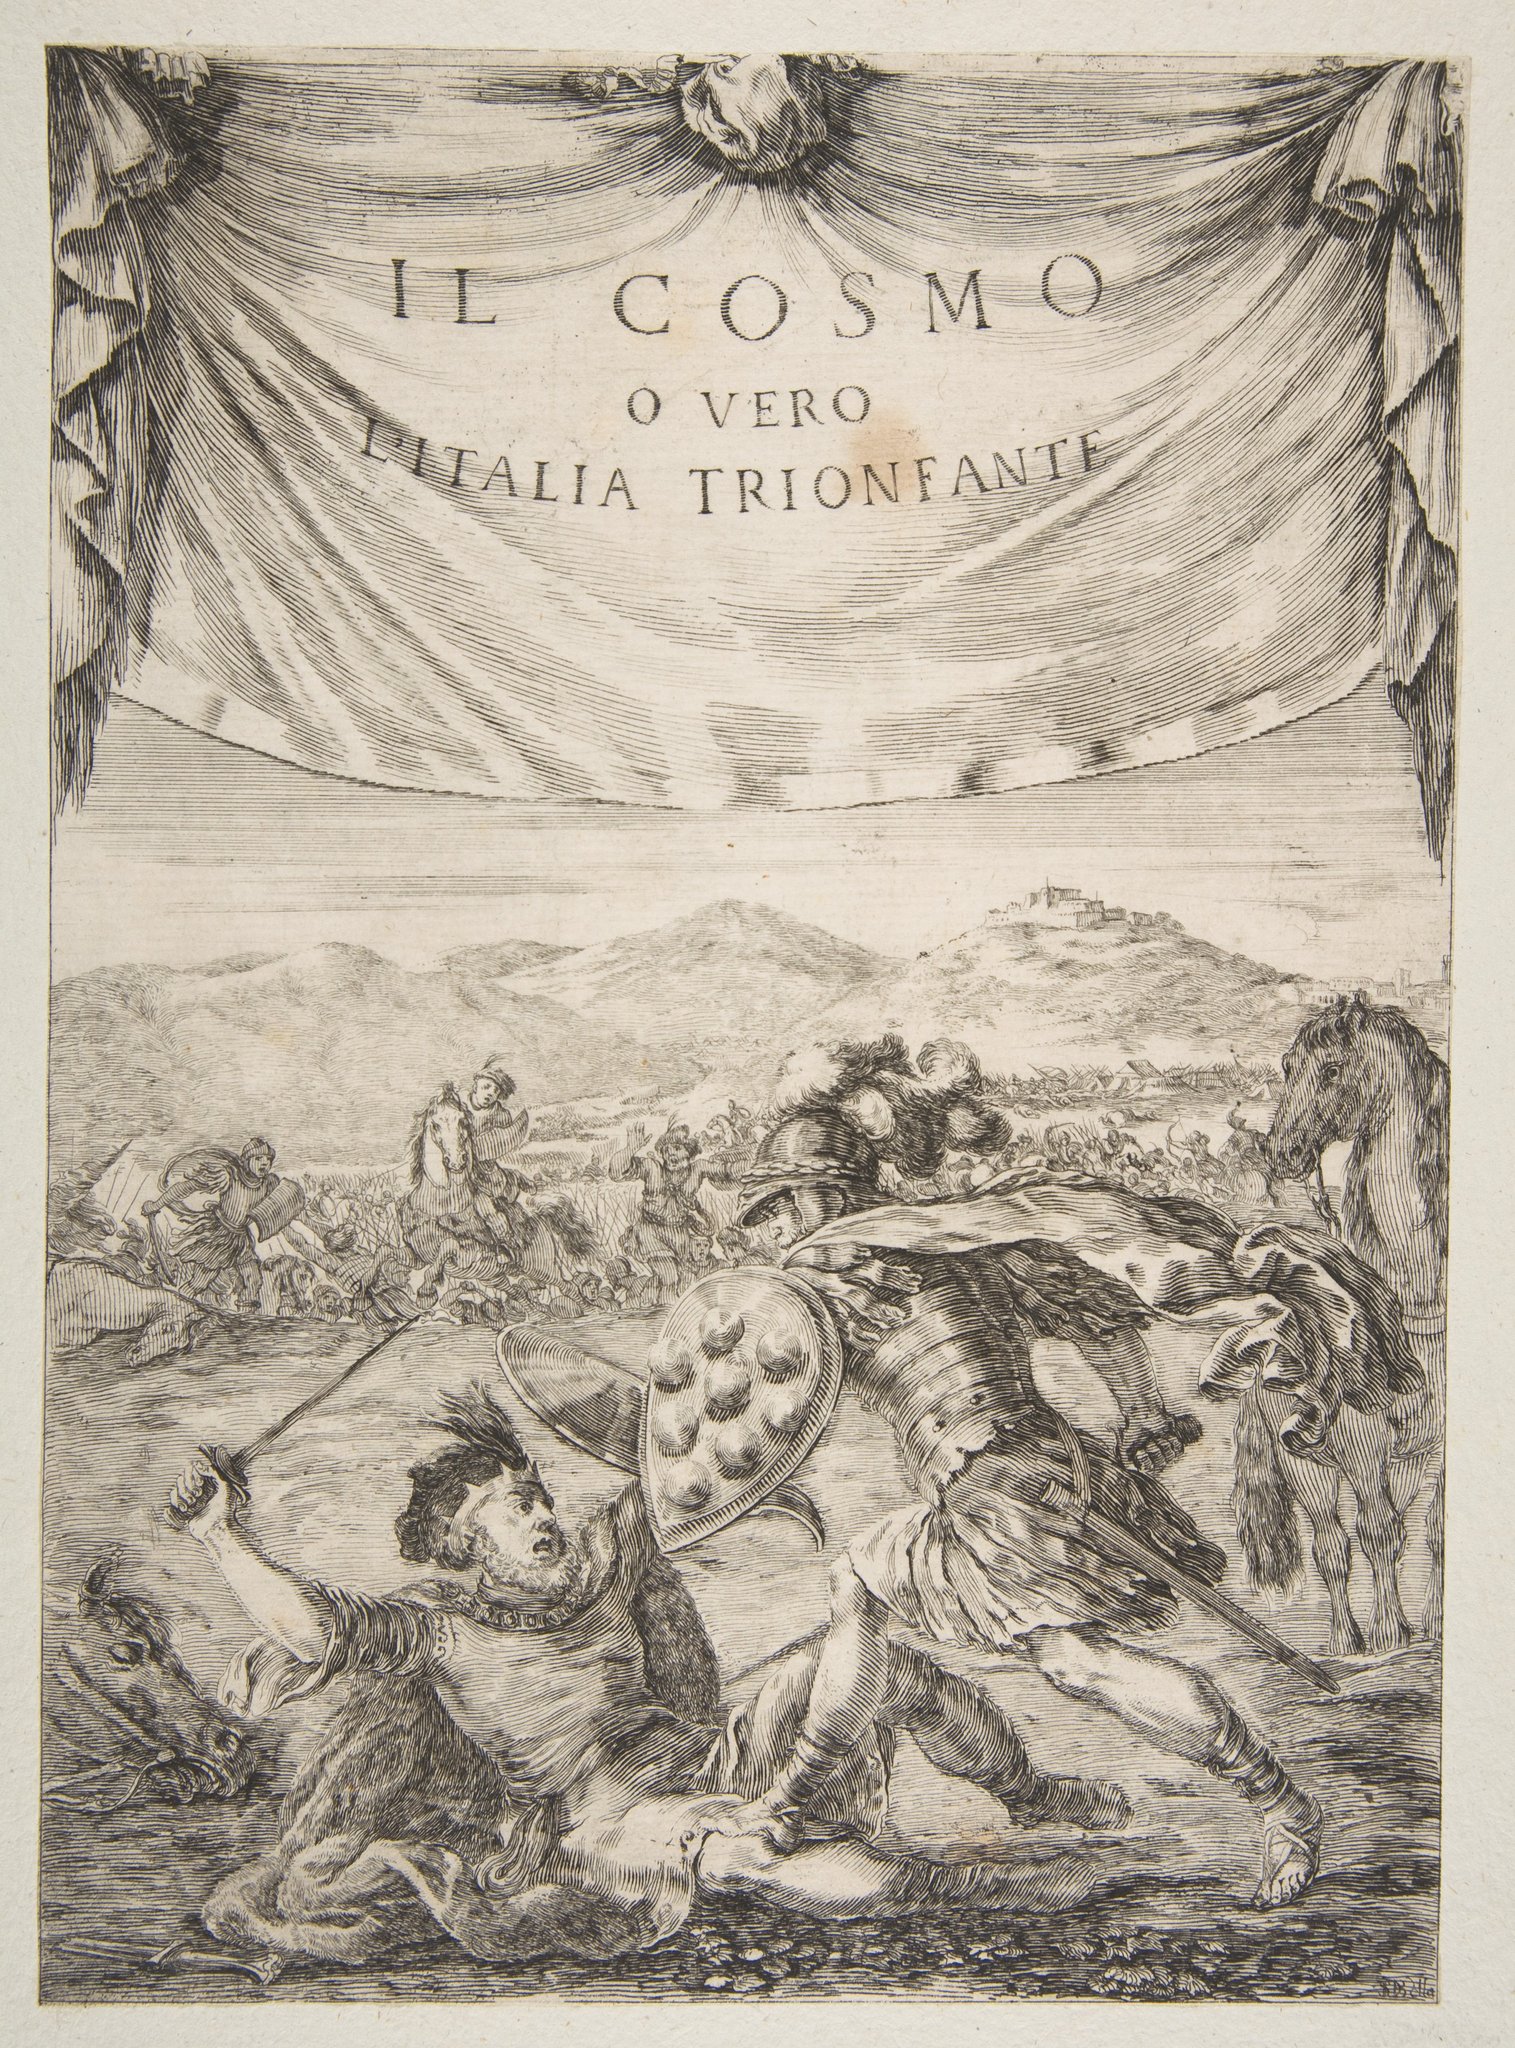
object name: print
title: Frontispiece for Il Cosmo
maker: stefano della bella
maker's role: artist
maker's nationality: italian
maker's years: 1610-1664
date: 1650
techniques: etching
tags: battles,soldiers,shields,swords,horses